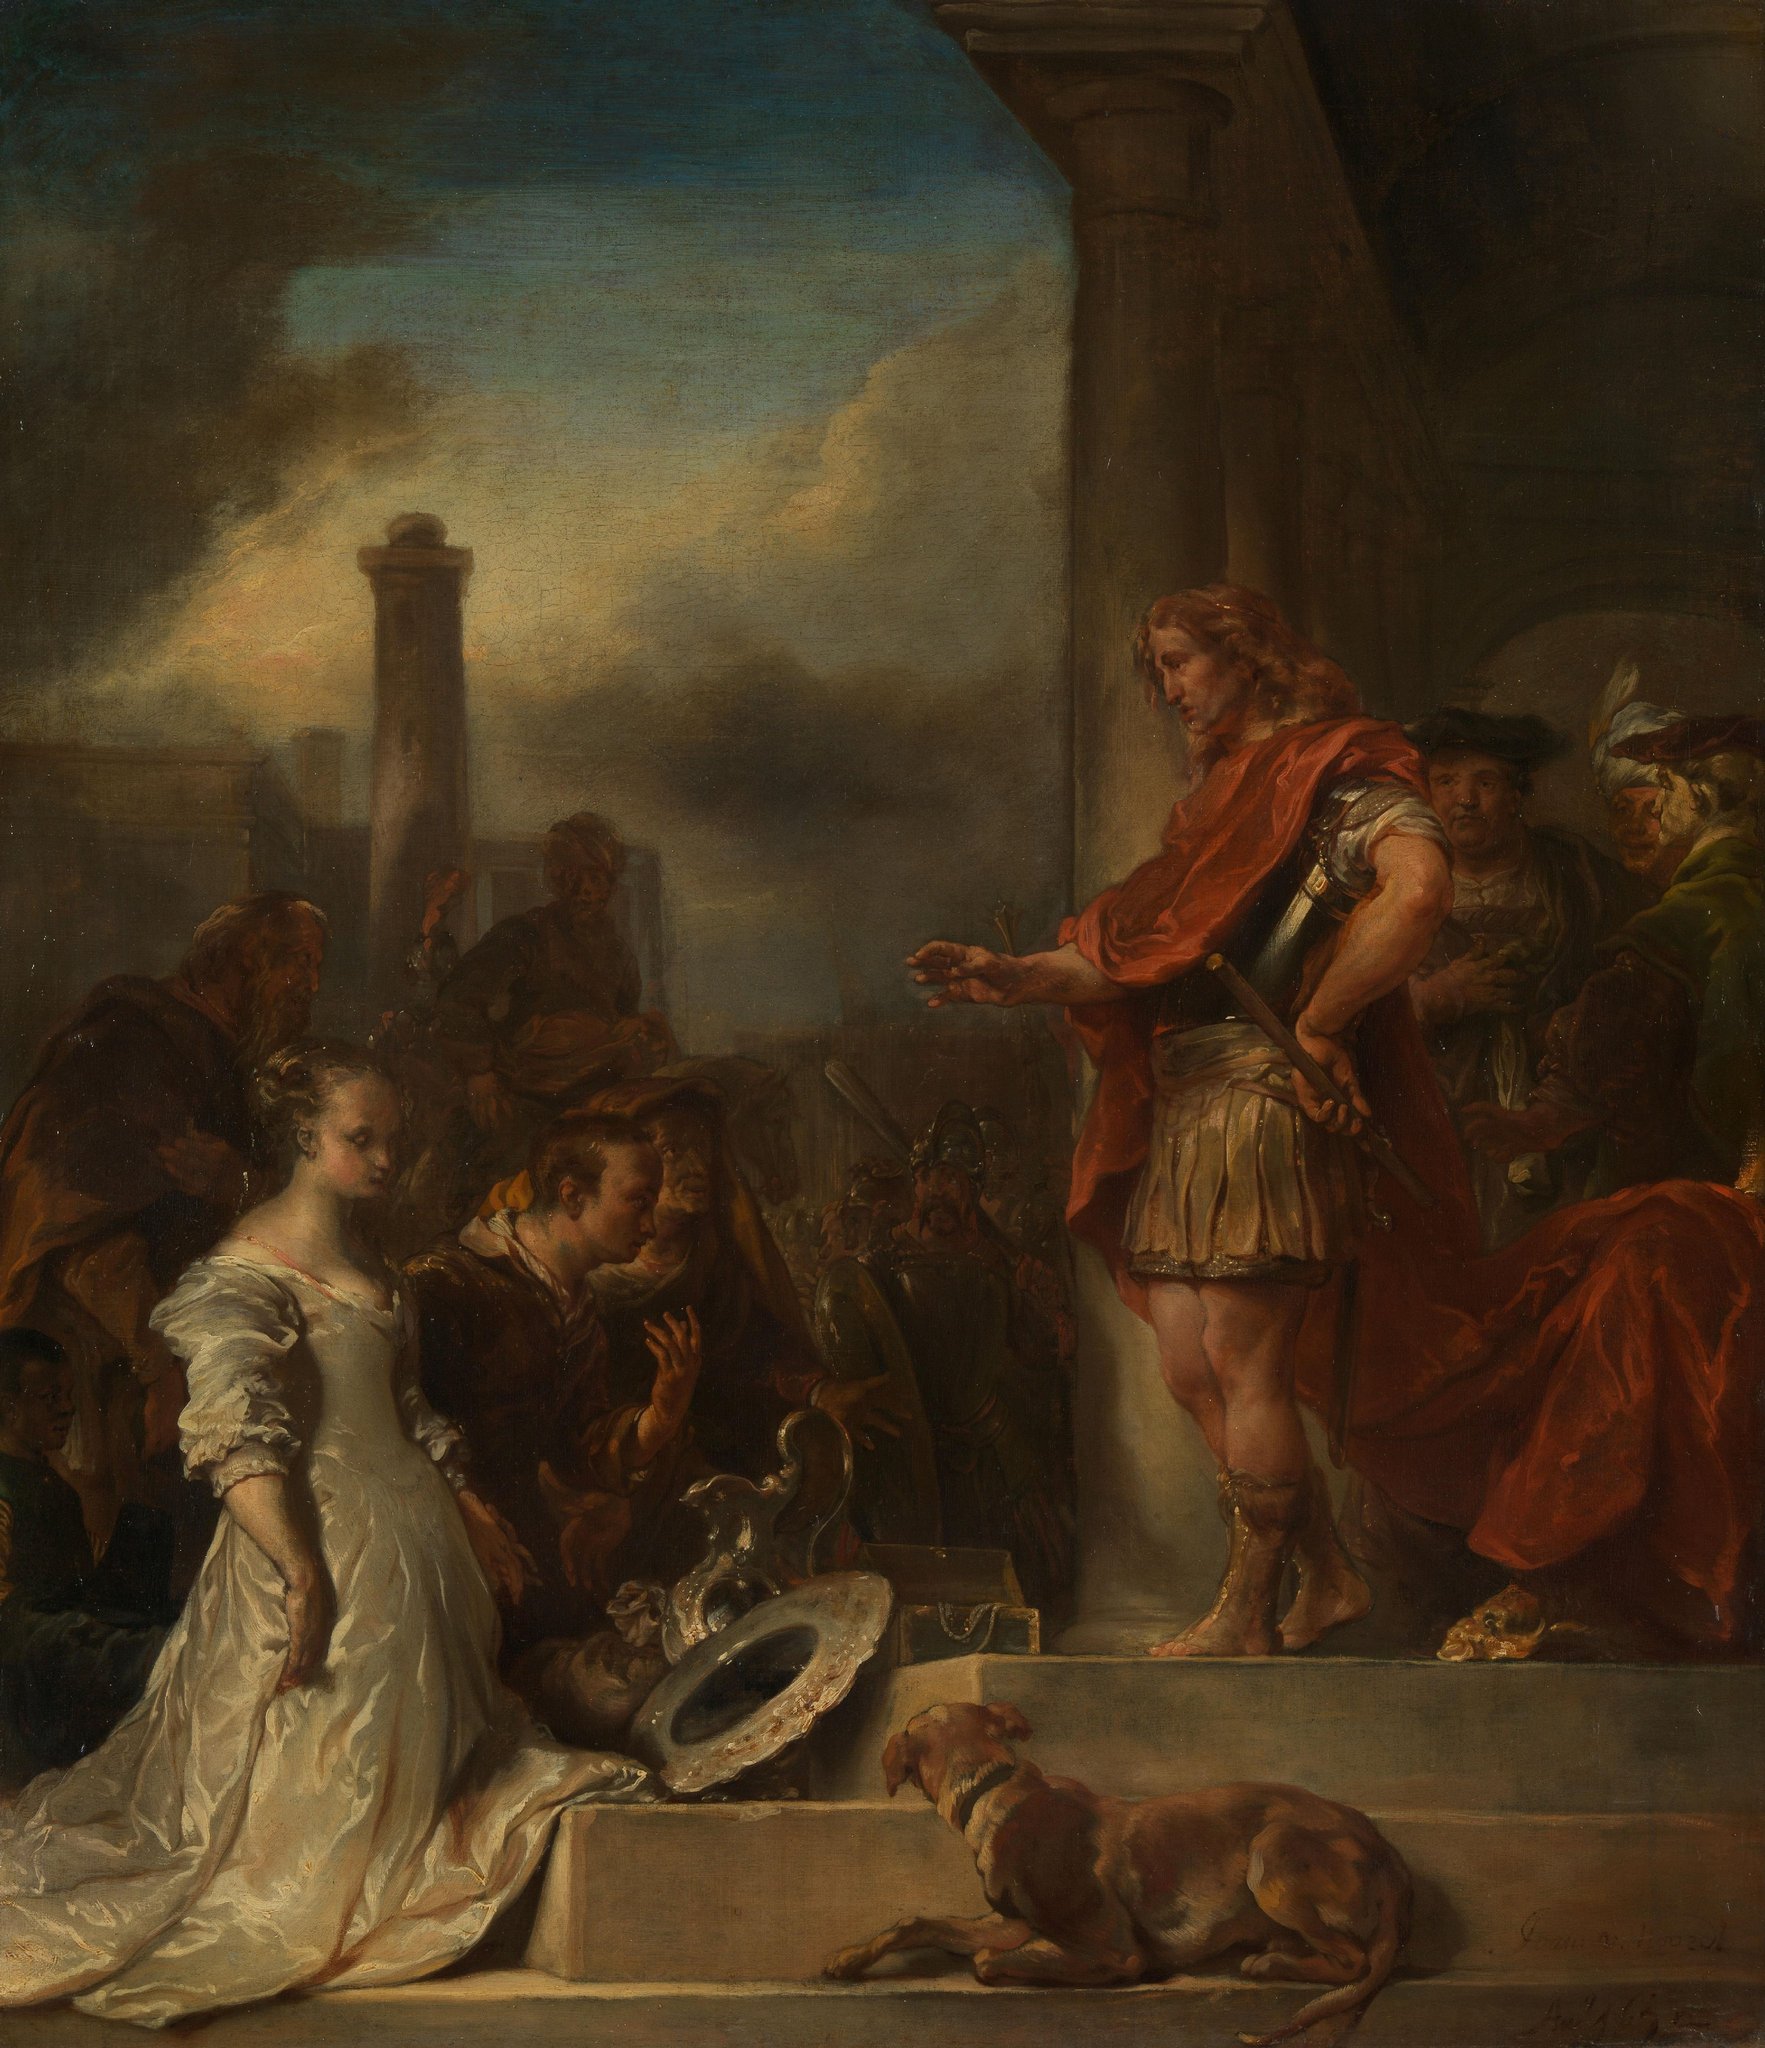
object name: painting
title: The continence of Scipio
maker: jan van noordt (1623-1676)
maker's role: draughtsman, painter, print maker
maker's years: 1623-1676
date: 1672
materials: canvas, oil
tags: the continence of scipio: he restores a captive woman to her bridegroom allucius, who kneels before him; the ransom offered by the bride's parents is given to allucius as a wedding-gift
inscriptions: signature and date: ‘Joan: v. Noordt Anº 1672’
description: De grootmoedigheid van Scipio. De man en de vrouw knielen voor de veldheer Scipio die met handgebaar het paar herenigt. Op de trappen ligt kostbaar vaatwerk. Rechts de adviseurs van Scipio, op de achtergrond soldaten en de gebouwen van de stad.